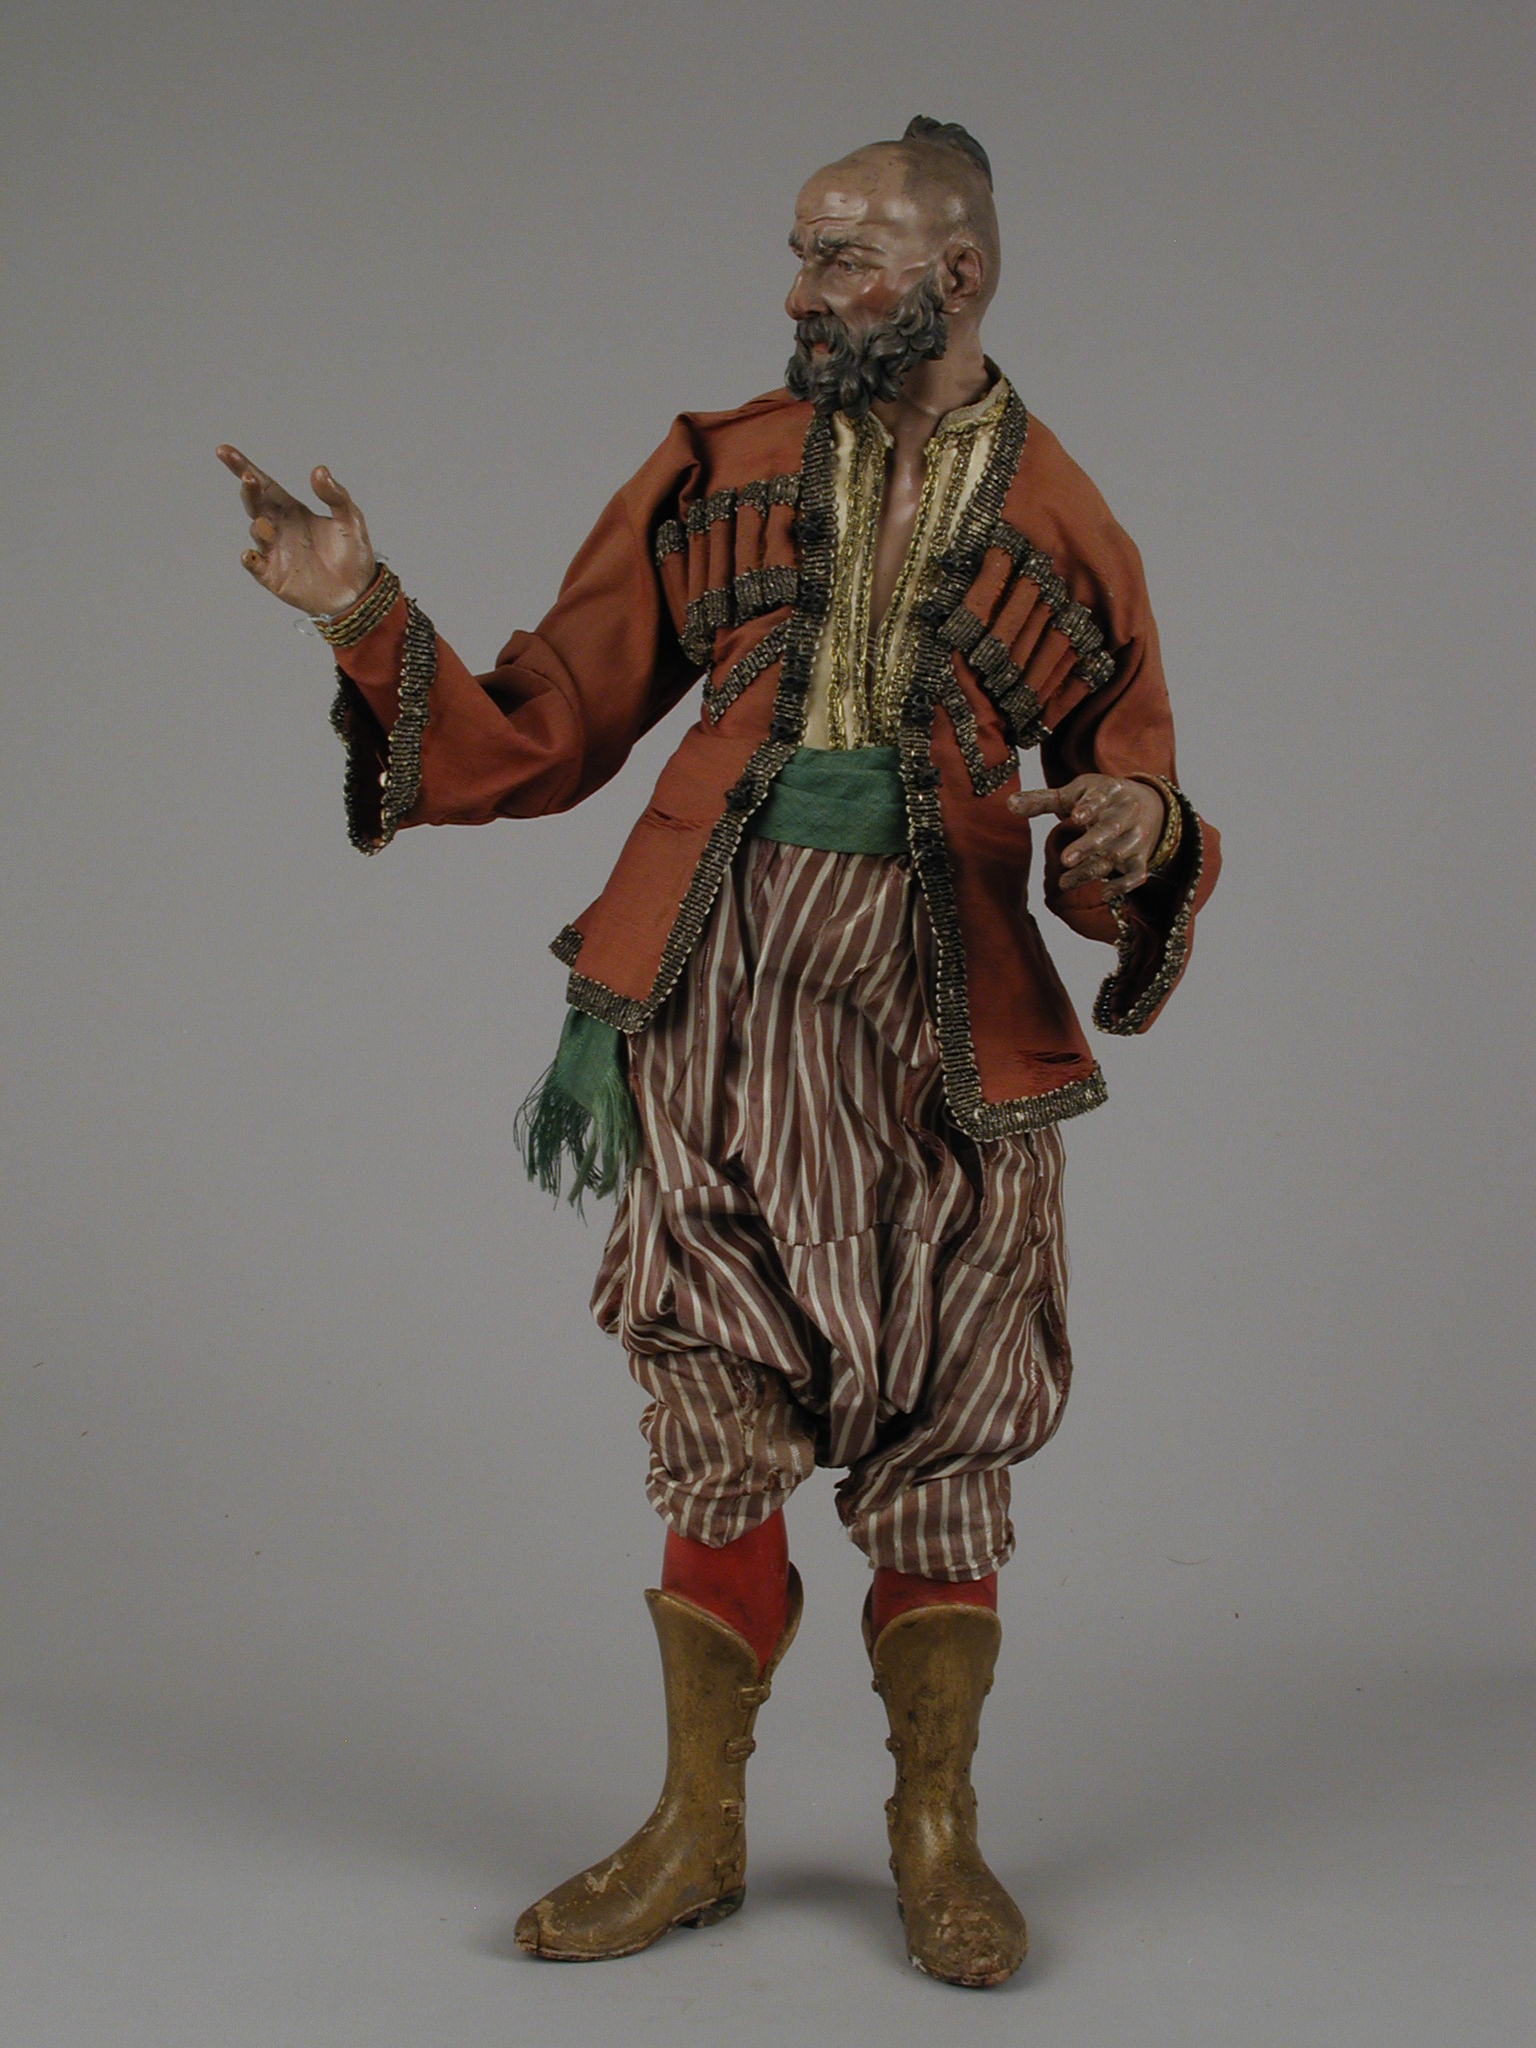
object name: crèche figure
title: King's attendant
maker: giuseppe sanmartino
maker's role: maker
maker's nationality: italian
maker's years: 1720-1793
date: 1751-1800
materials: brass, gold, metal thread, textile, silk, silver, terracotta, fiber, velvet, metal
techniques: polychrome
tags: men